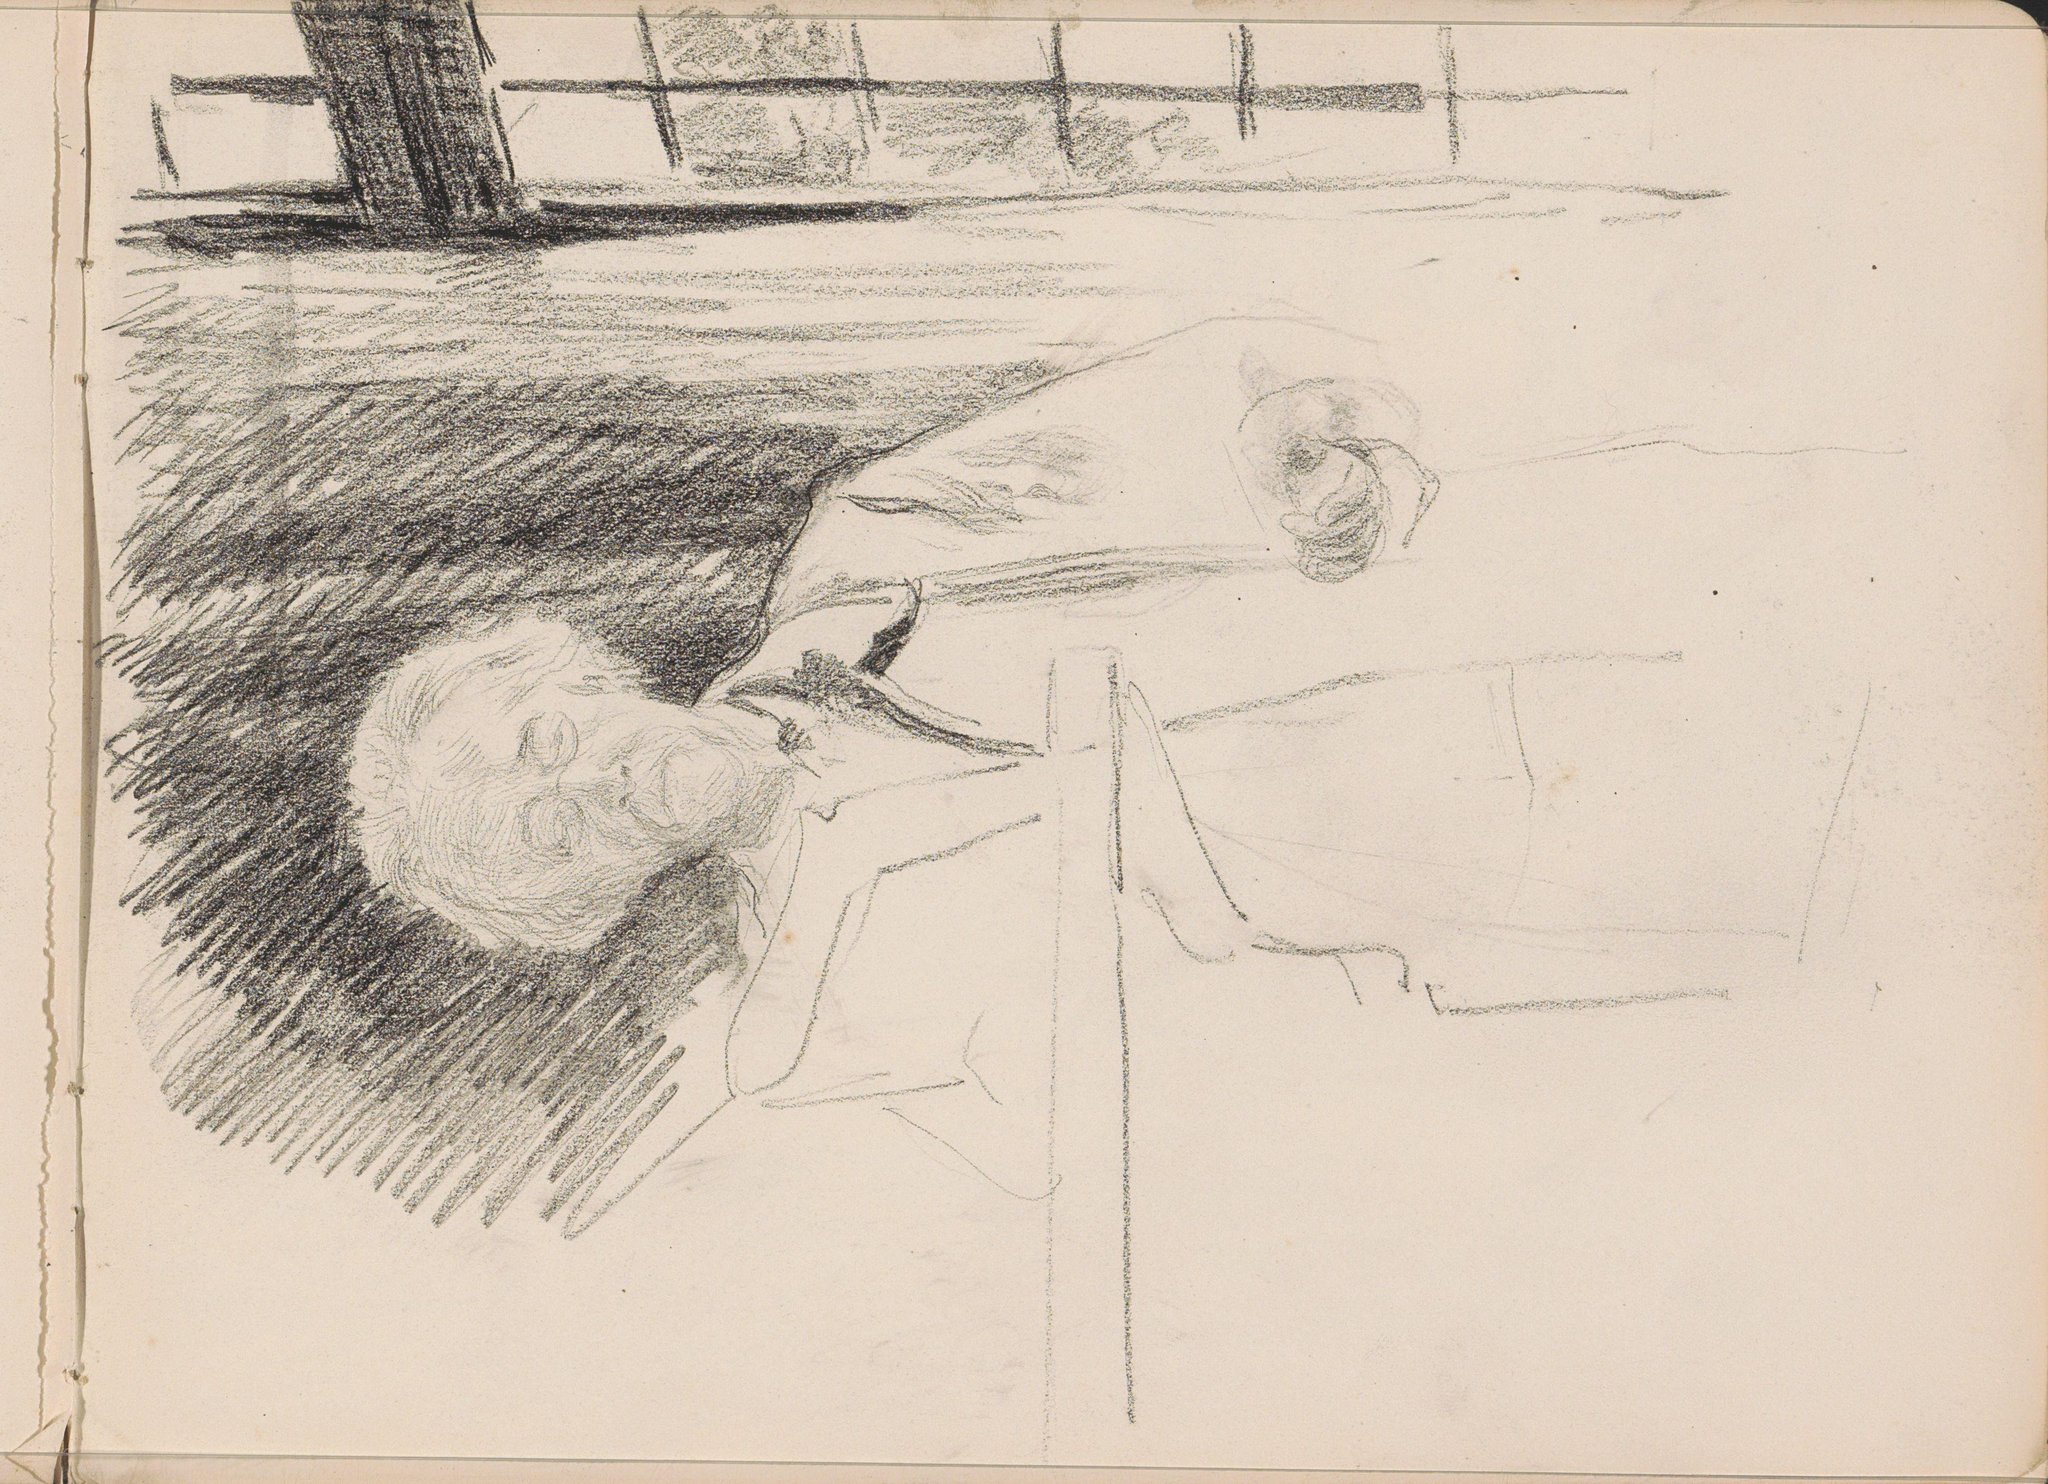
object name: sketchbook leaf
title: Interieur met een man staand achter een katheder bij een raam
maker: a.a.l. de grammont-hubrecht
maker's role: draughtsman, painter, print maker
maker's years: 1855-1913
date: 1865-1913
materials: chalk, paper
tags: standing figure, window, lectern, adult man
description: De man heeft een map onder de rechterarm. Blad 28 recto uit een schetsboek met 39 bladen.